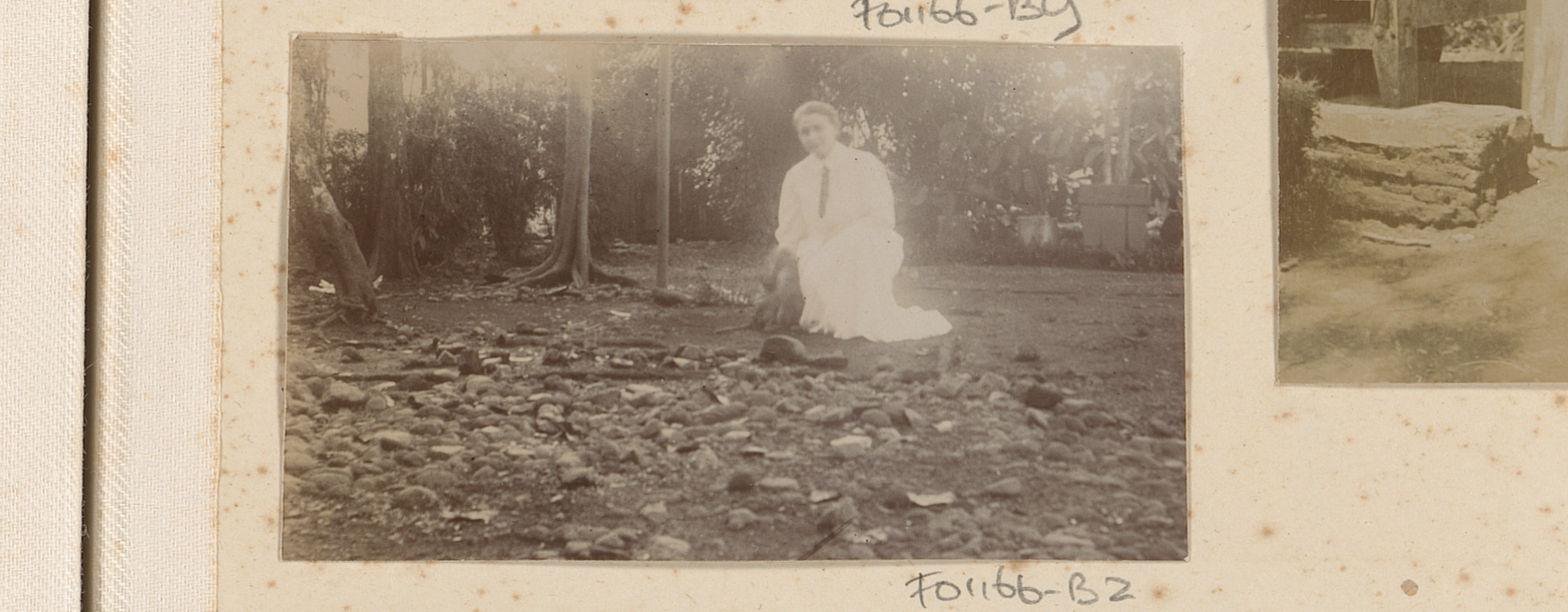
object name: album leaf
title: Nederlandse vrouw met een aap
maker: Anonymous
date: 1880-1910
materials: photographic support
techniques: gelatin silver print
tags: adult woman, monkeys, apes, historical persons, dutch east indies, the